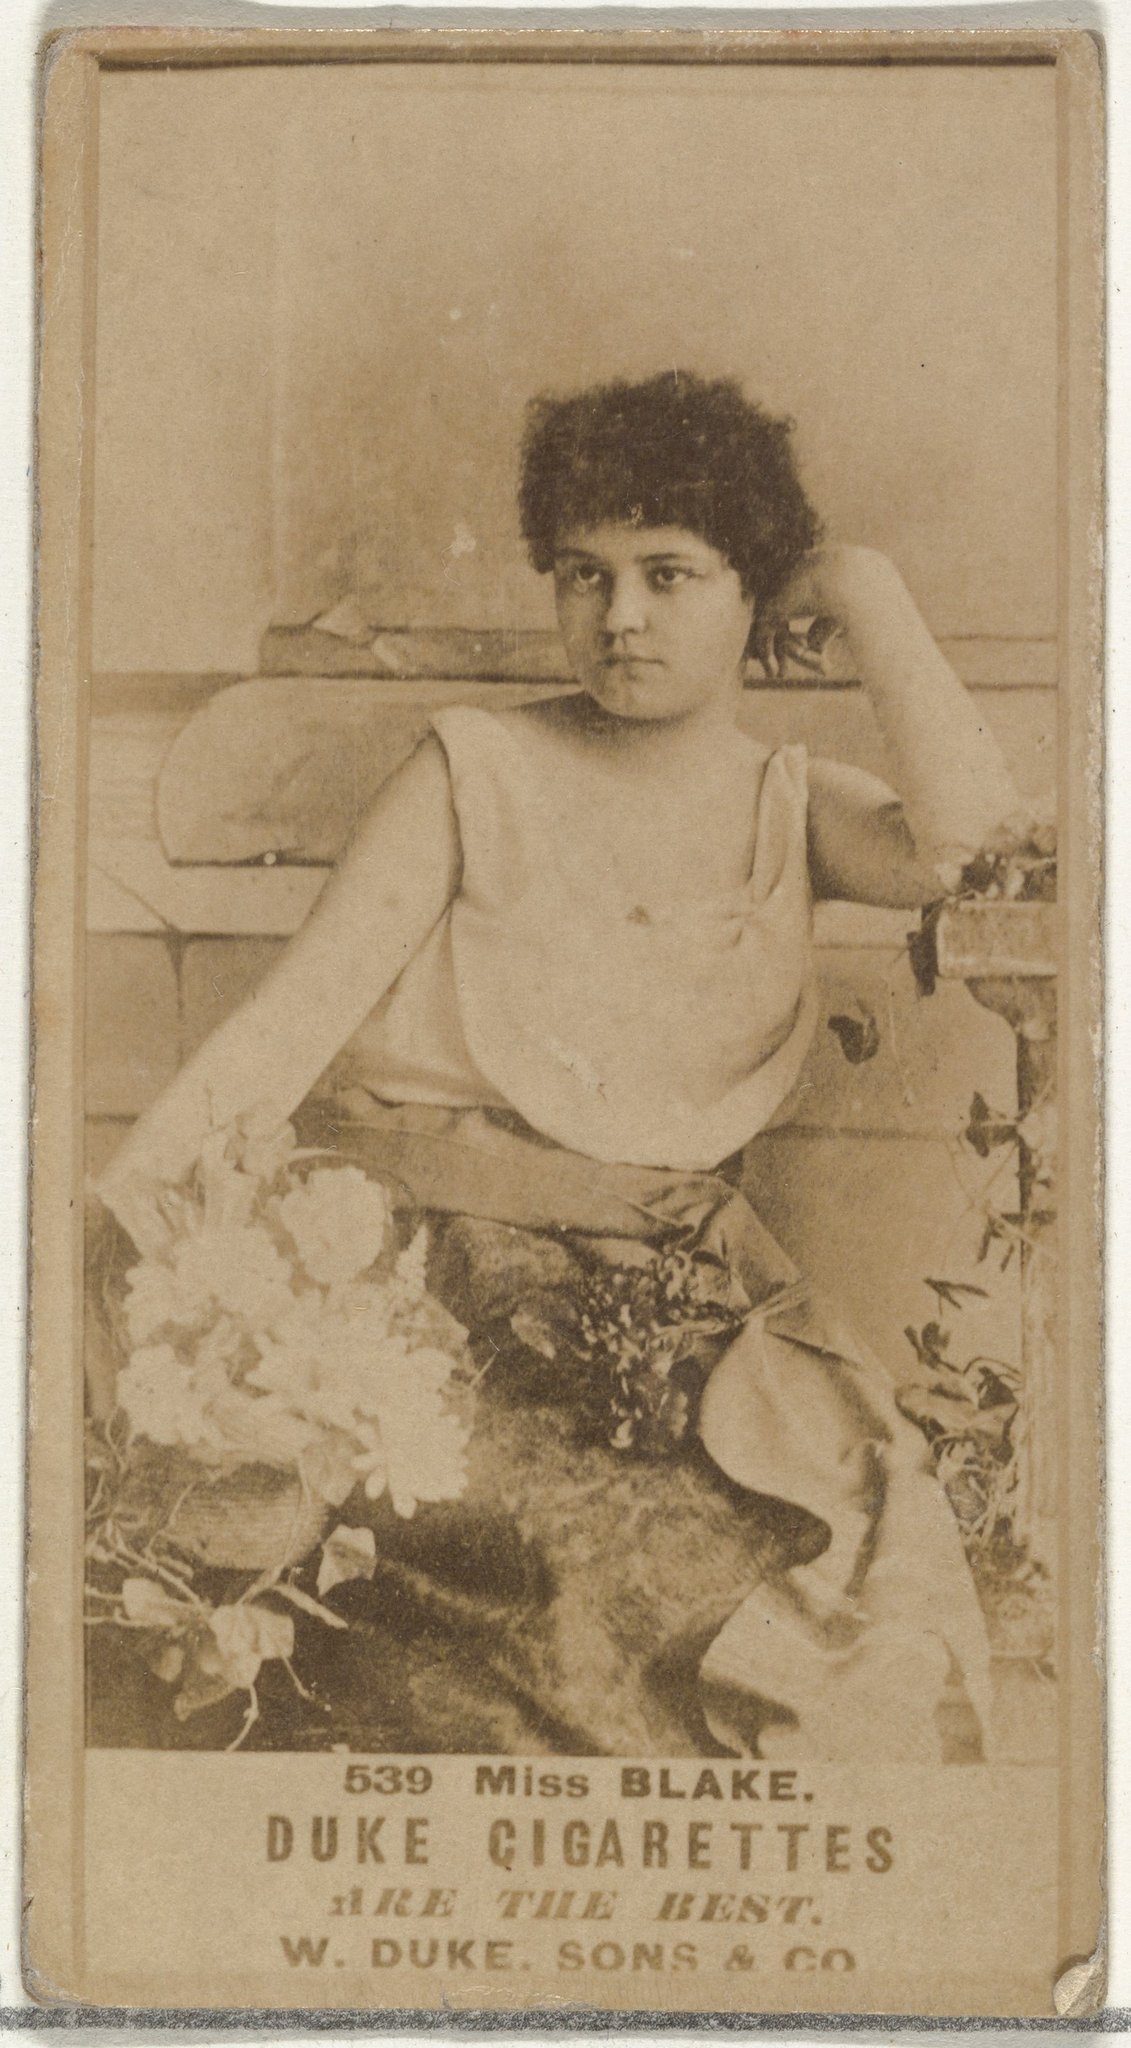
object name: photograph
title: Card Number 539, Miss Blake, from the Actors and Actresses series (N145-7) issued by Duke Sons & Co. to promote Duke Cigarettes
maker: w. duke, sons & co.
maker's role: publisher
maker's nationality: american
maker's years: 1870-1920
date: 1880-1889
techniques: albumen silver print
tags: portraits,women,actresses